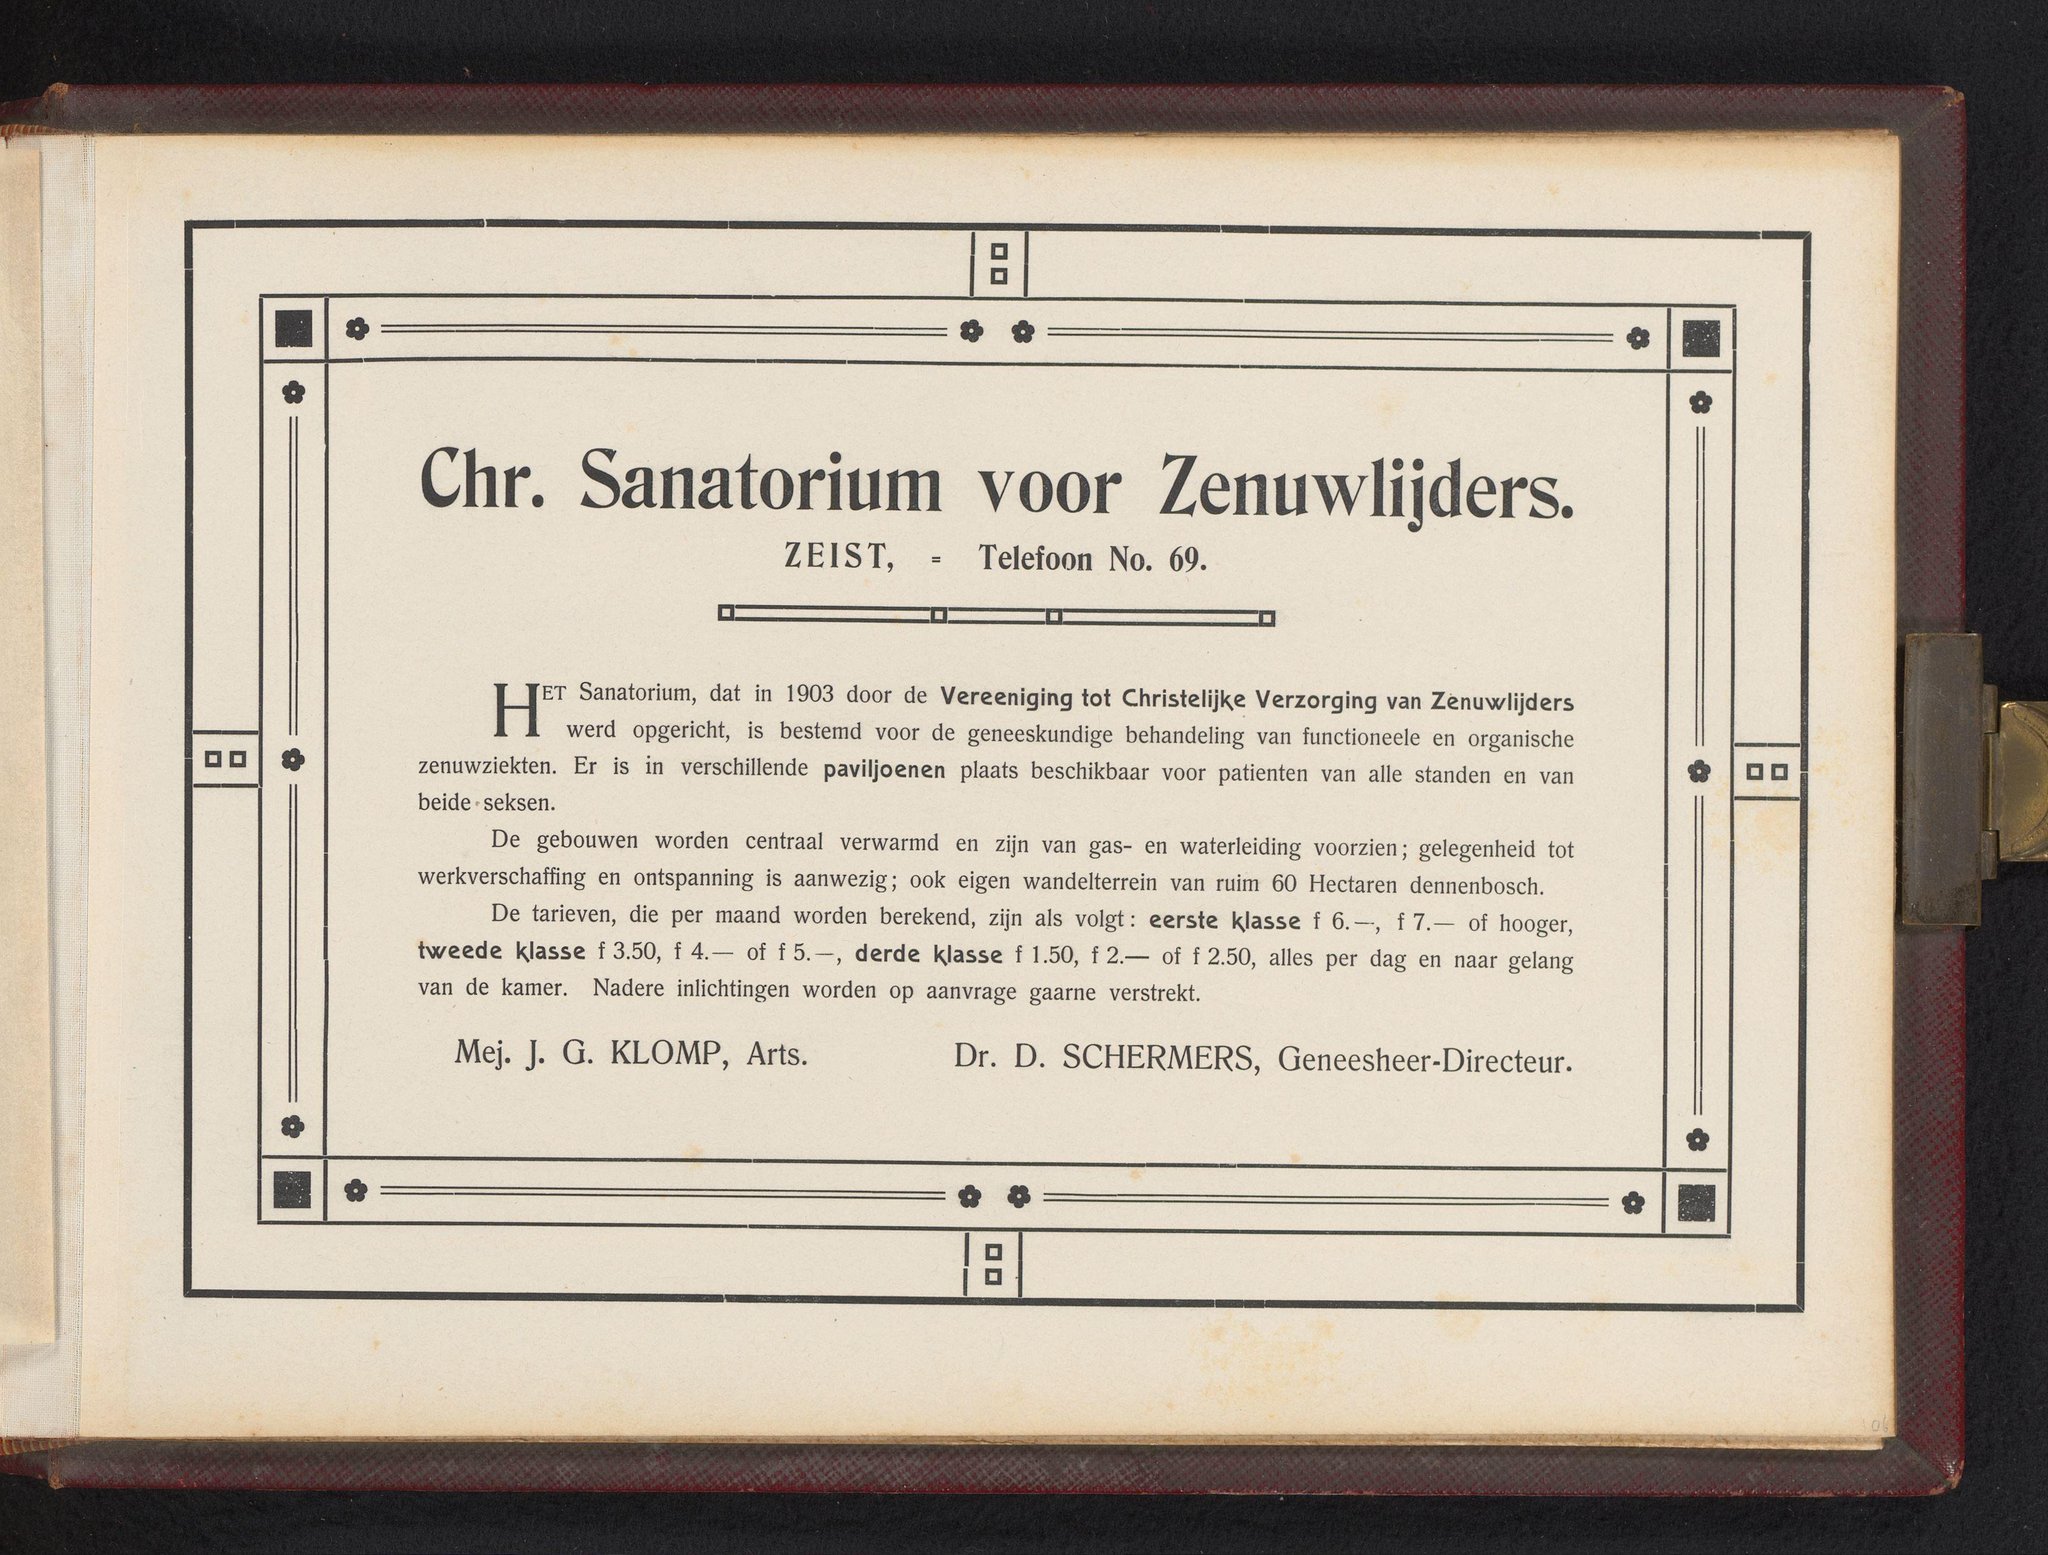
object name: album leaf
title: Advertentie voor Chr. Sanatorium voor Zenuwlijders te Zeist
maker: Anonymous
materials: paper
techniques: printing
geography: netherlands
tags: advertising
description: Deze pagina maakt deel uit van een album.